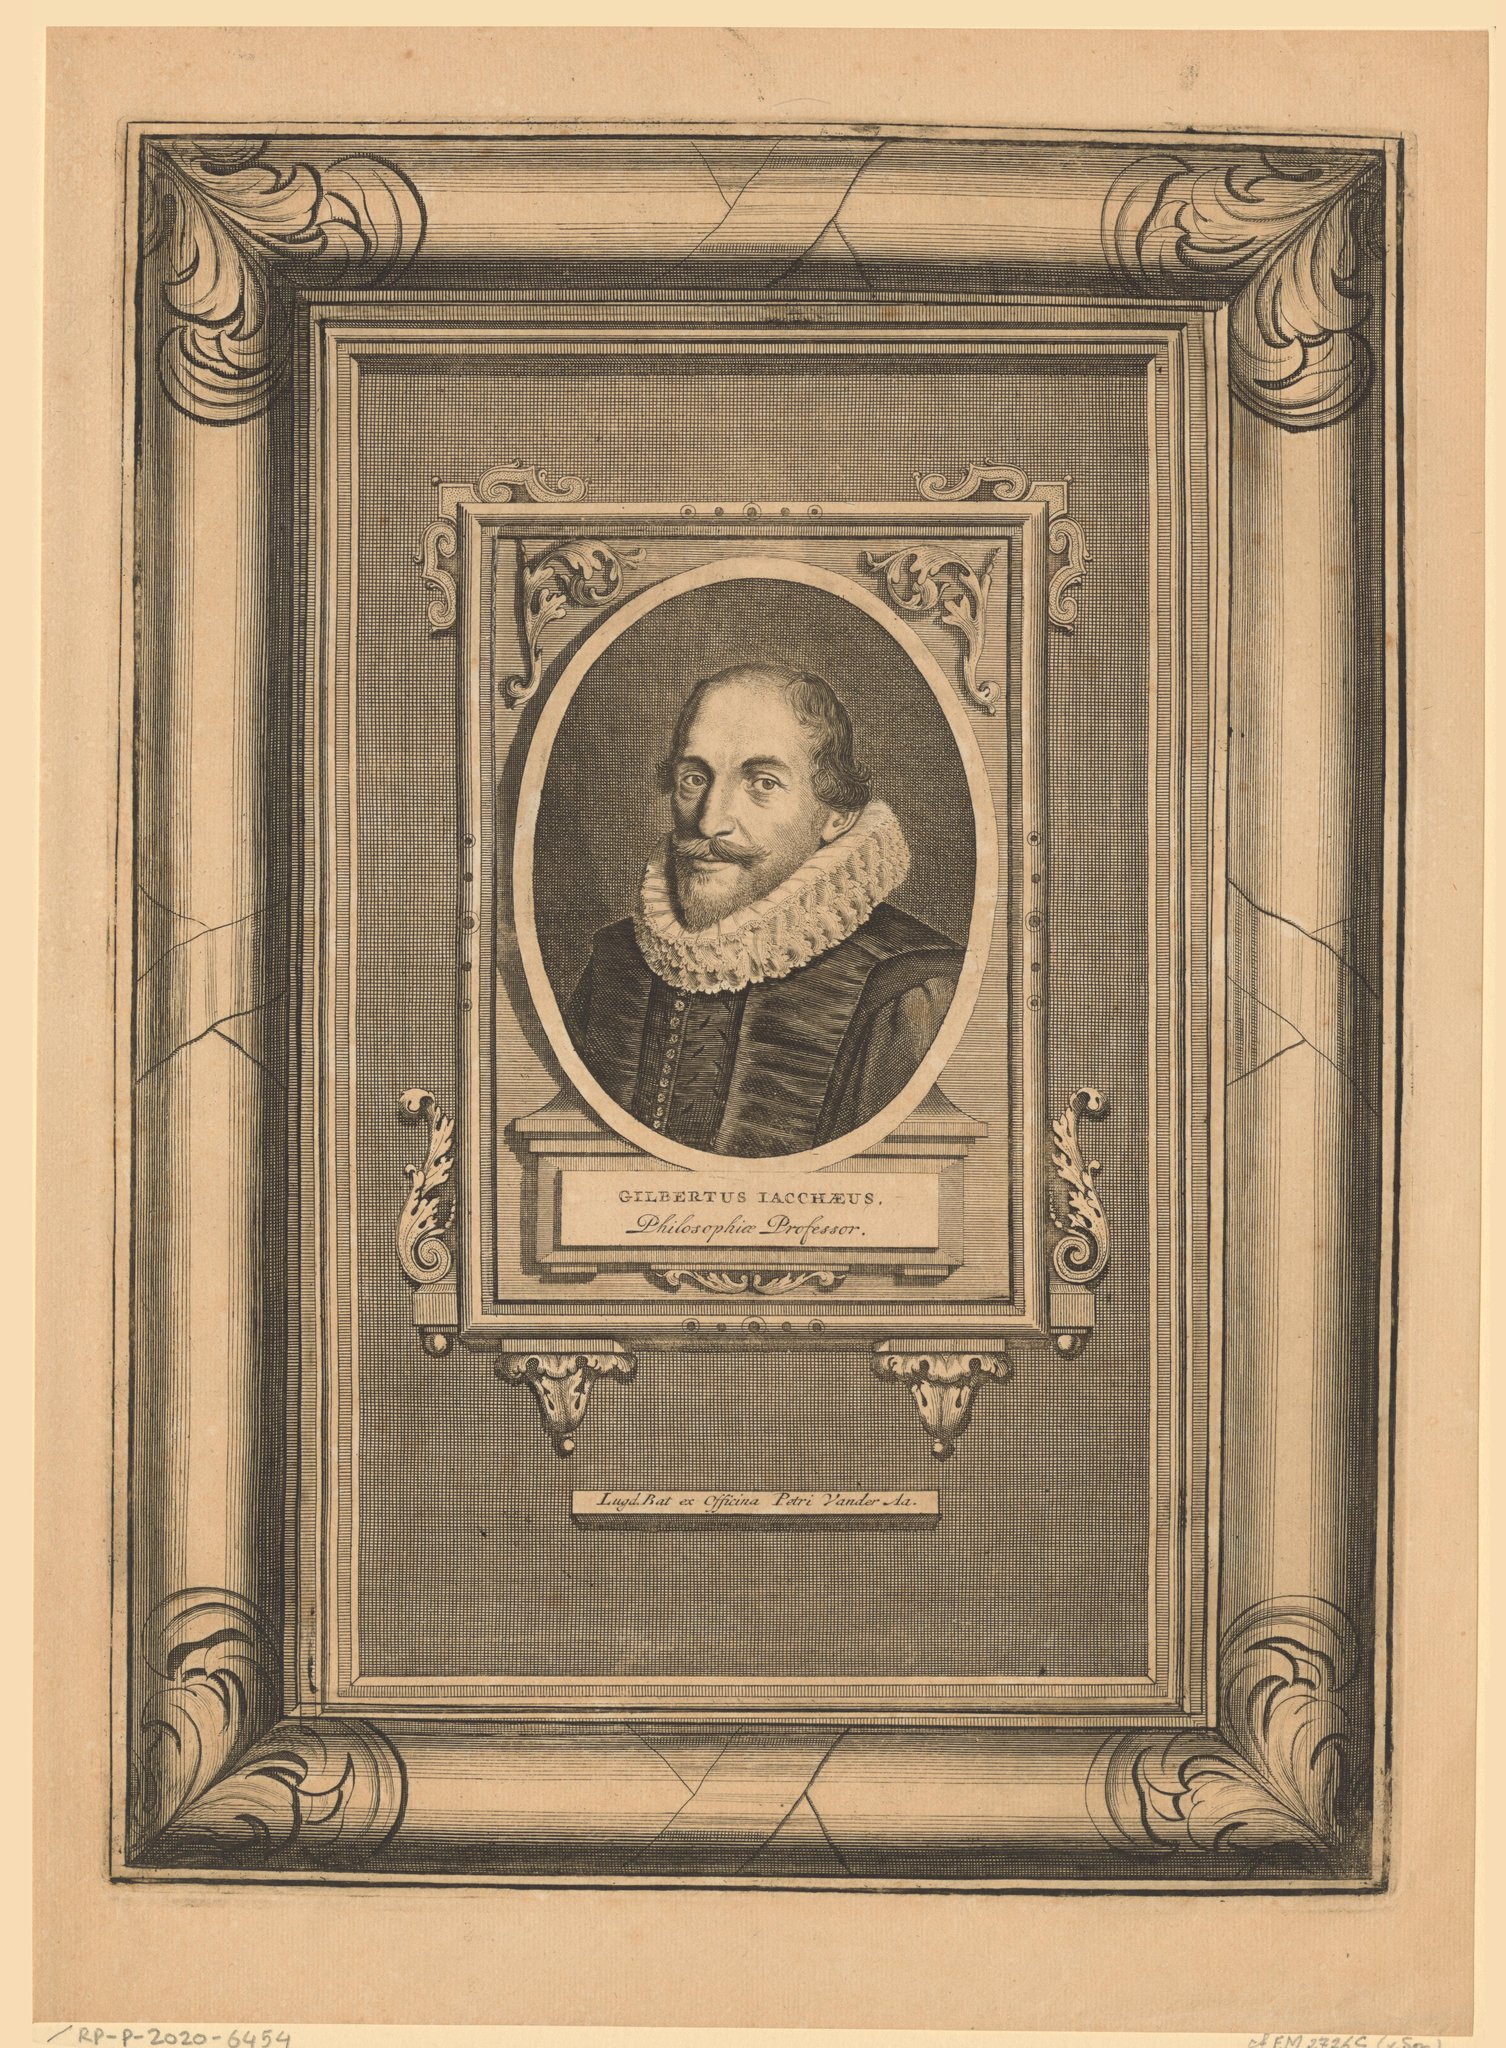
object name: print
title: Portret van Gilbertus Jacchaeus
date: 1716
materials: paper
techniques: engraving, etching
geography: leiden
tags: leiden, scholar, philosopher, historical persons, professor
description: Prent zonder tweede omlijsting gebruikt in: Fundatoris curatorum et professorum celeberrimorum, (...) academia Lugduno-Batava (...). Leiden: Pieter van der Aa, [ca. 1716].